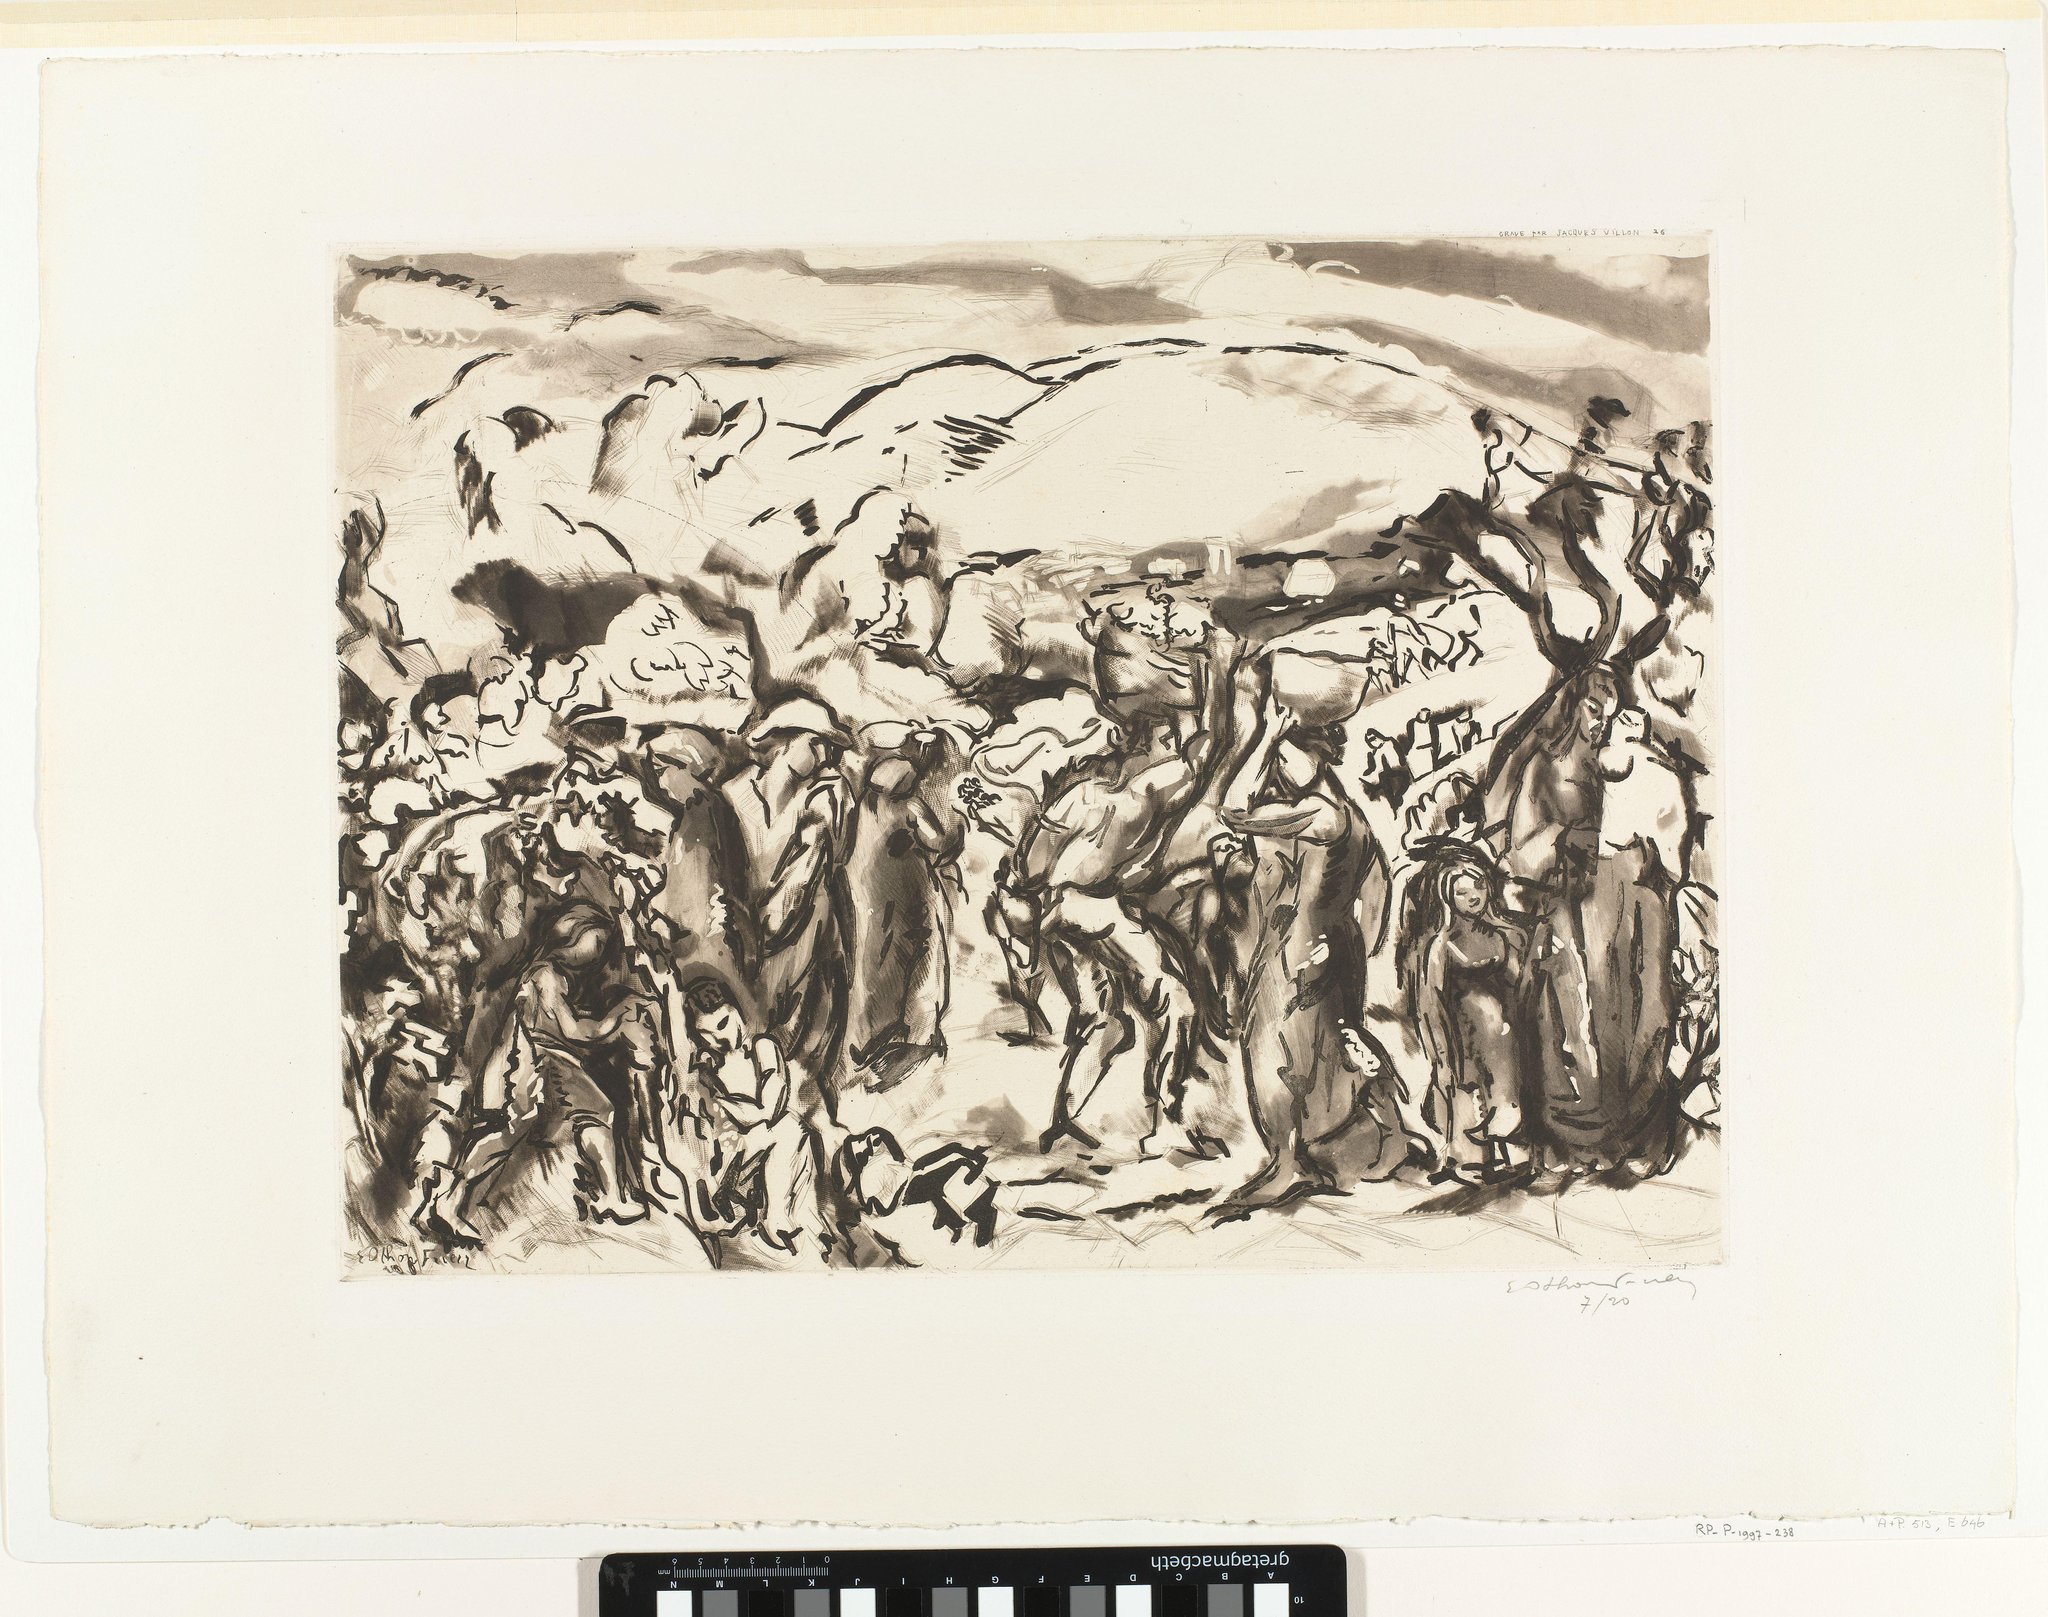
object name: print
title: Friesz, Les Vendanges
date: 1926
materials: paper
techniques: aquatint, drypoint, roulette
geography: paris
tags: harvest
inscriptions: collector's mark: Lugt 2228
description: Druivenplukkers met manden druiven op hun schouders. Een berg op de achtergrond.